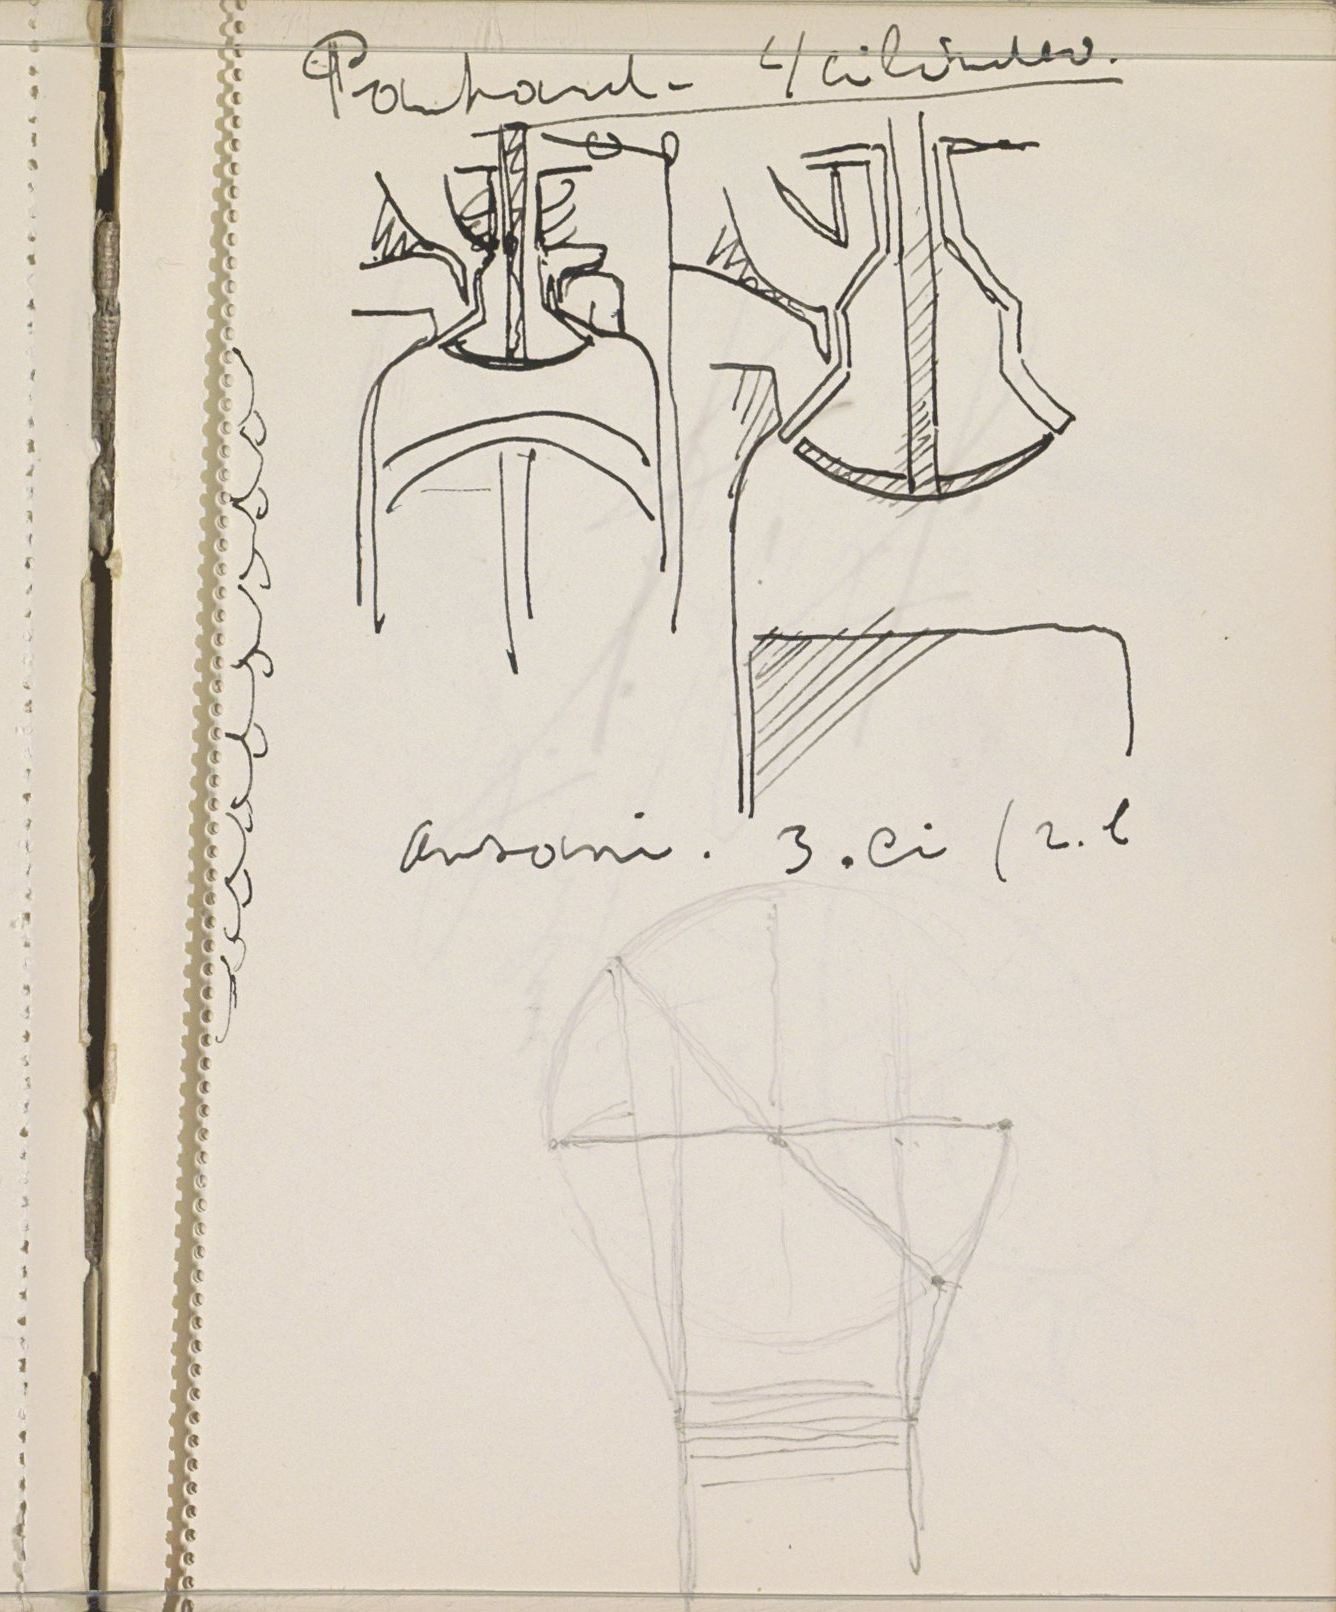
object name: sketchbook leaf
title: Studies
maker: reijer stolk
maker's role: draughtsman, print maker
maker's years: 1896-1945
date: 1906-1945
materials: ink, paper, pencil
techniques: pen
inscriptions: annotation: ‘Po[...]rd - 4 cilinders./ anso[...]i 3. ci/ 2. l’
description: Mogelijk vliegtuigonderdelen. Blad 20 recto uit een schetsboek met 42 bladen.